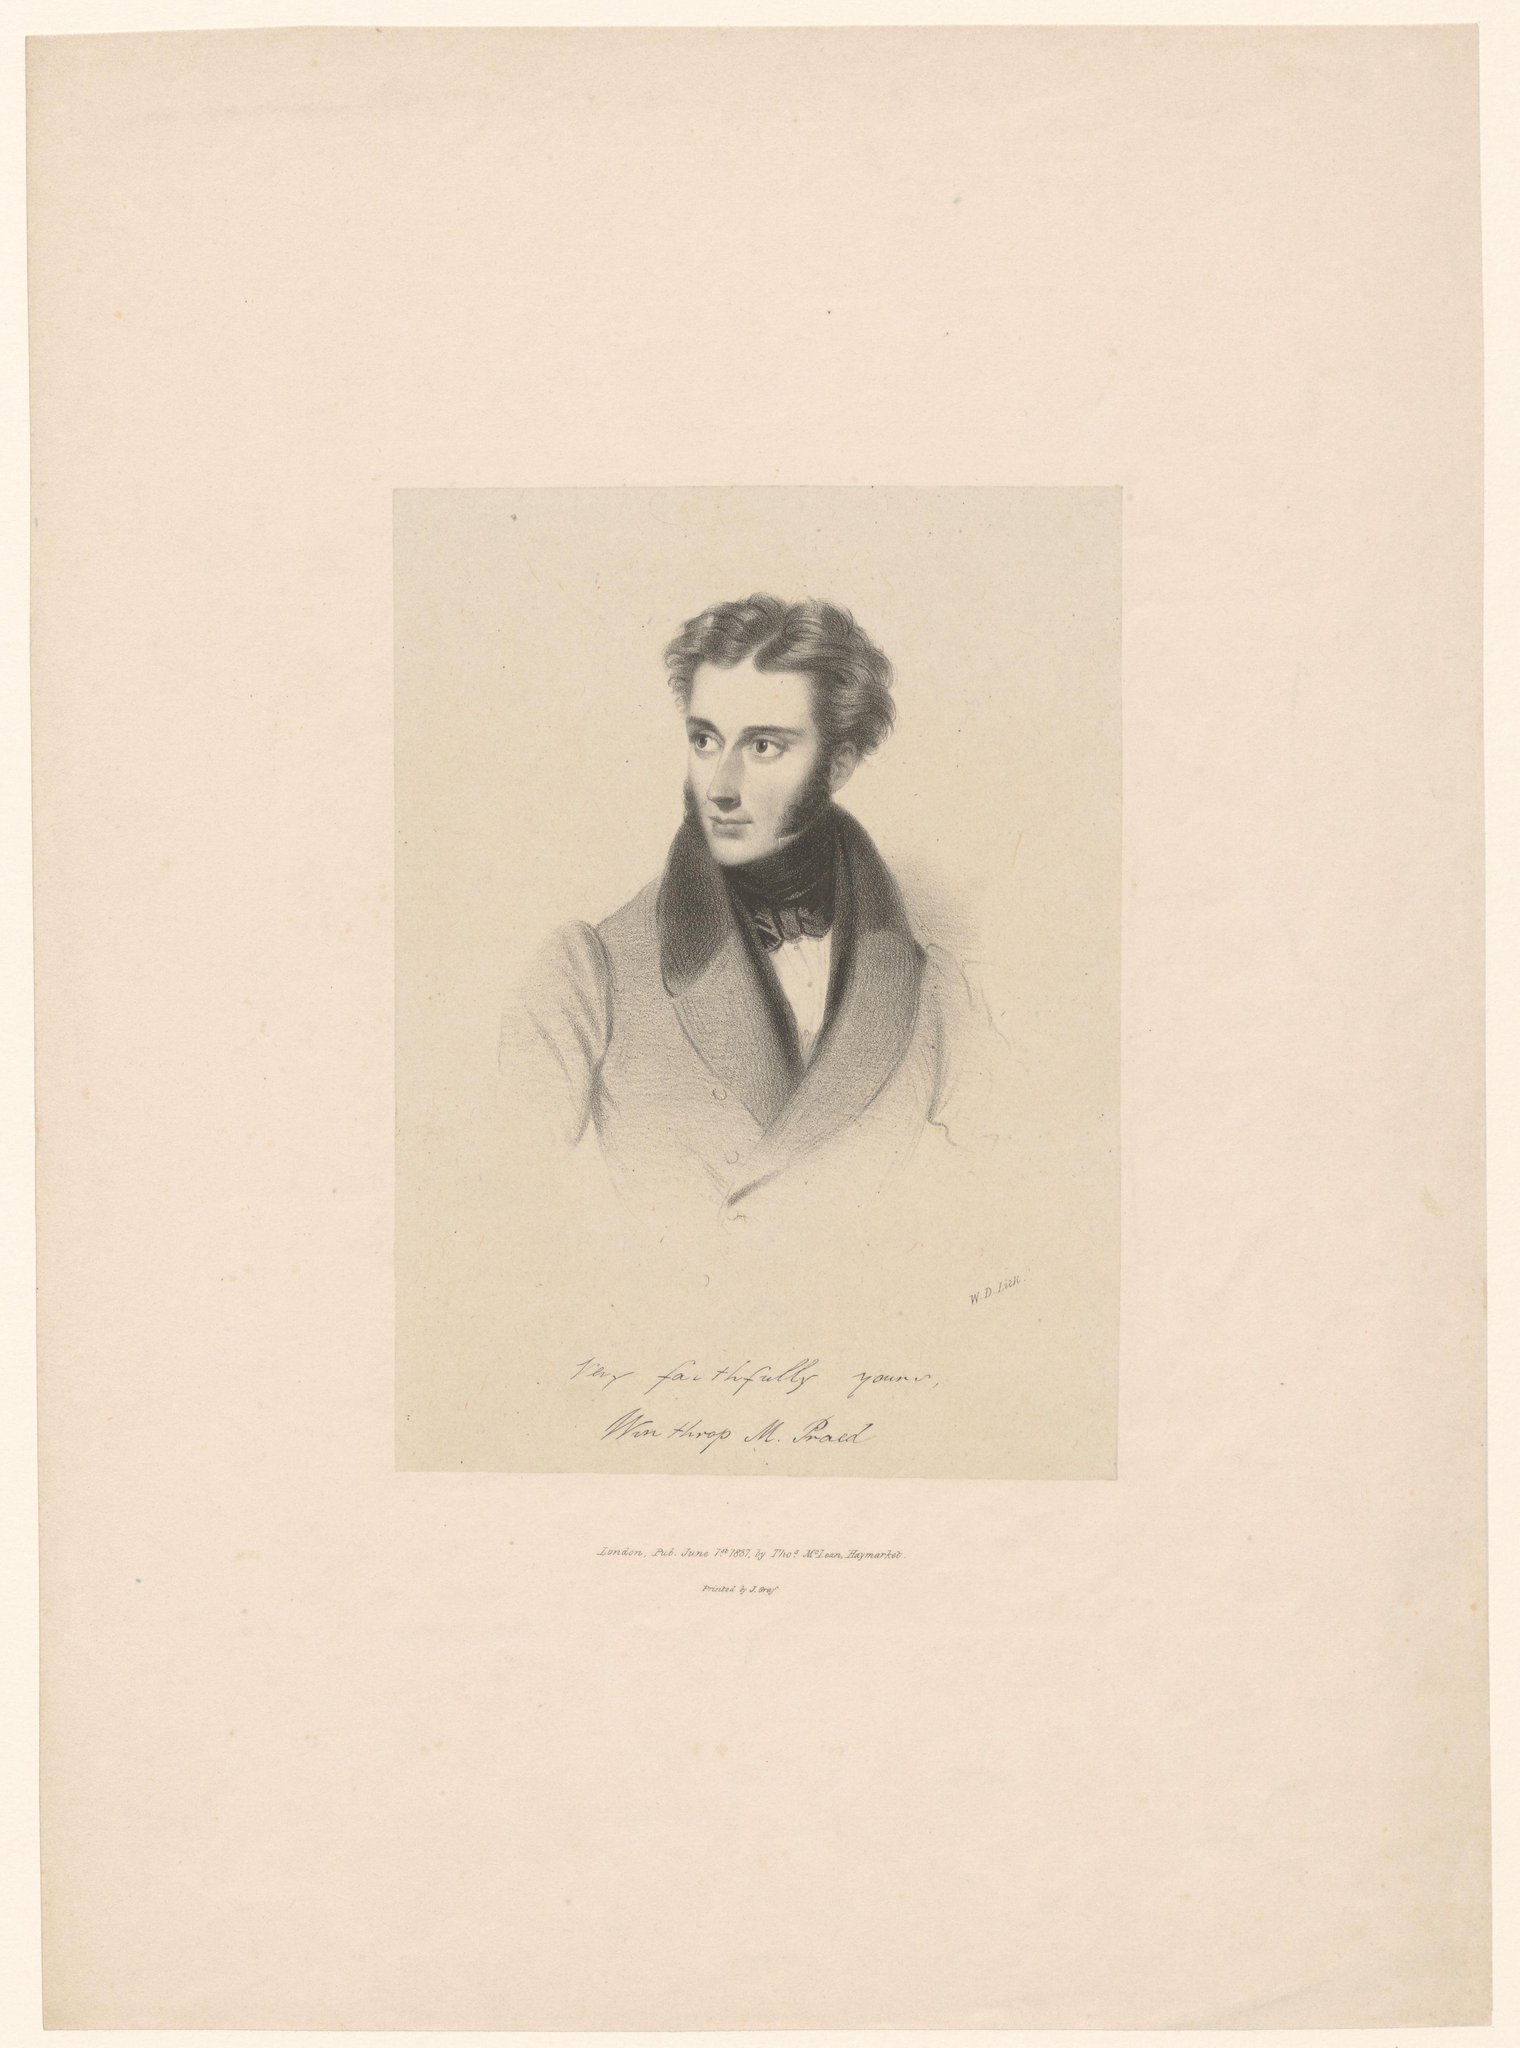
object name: print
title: Portret van Winthrop Mackworth Praed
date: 1837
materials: paper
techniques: lithograph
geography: london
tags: adult man, historical persons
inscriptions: collector's mark: Lugt 2228